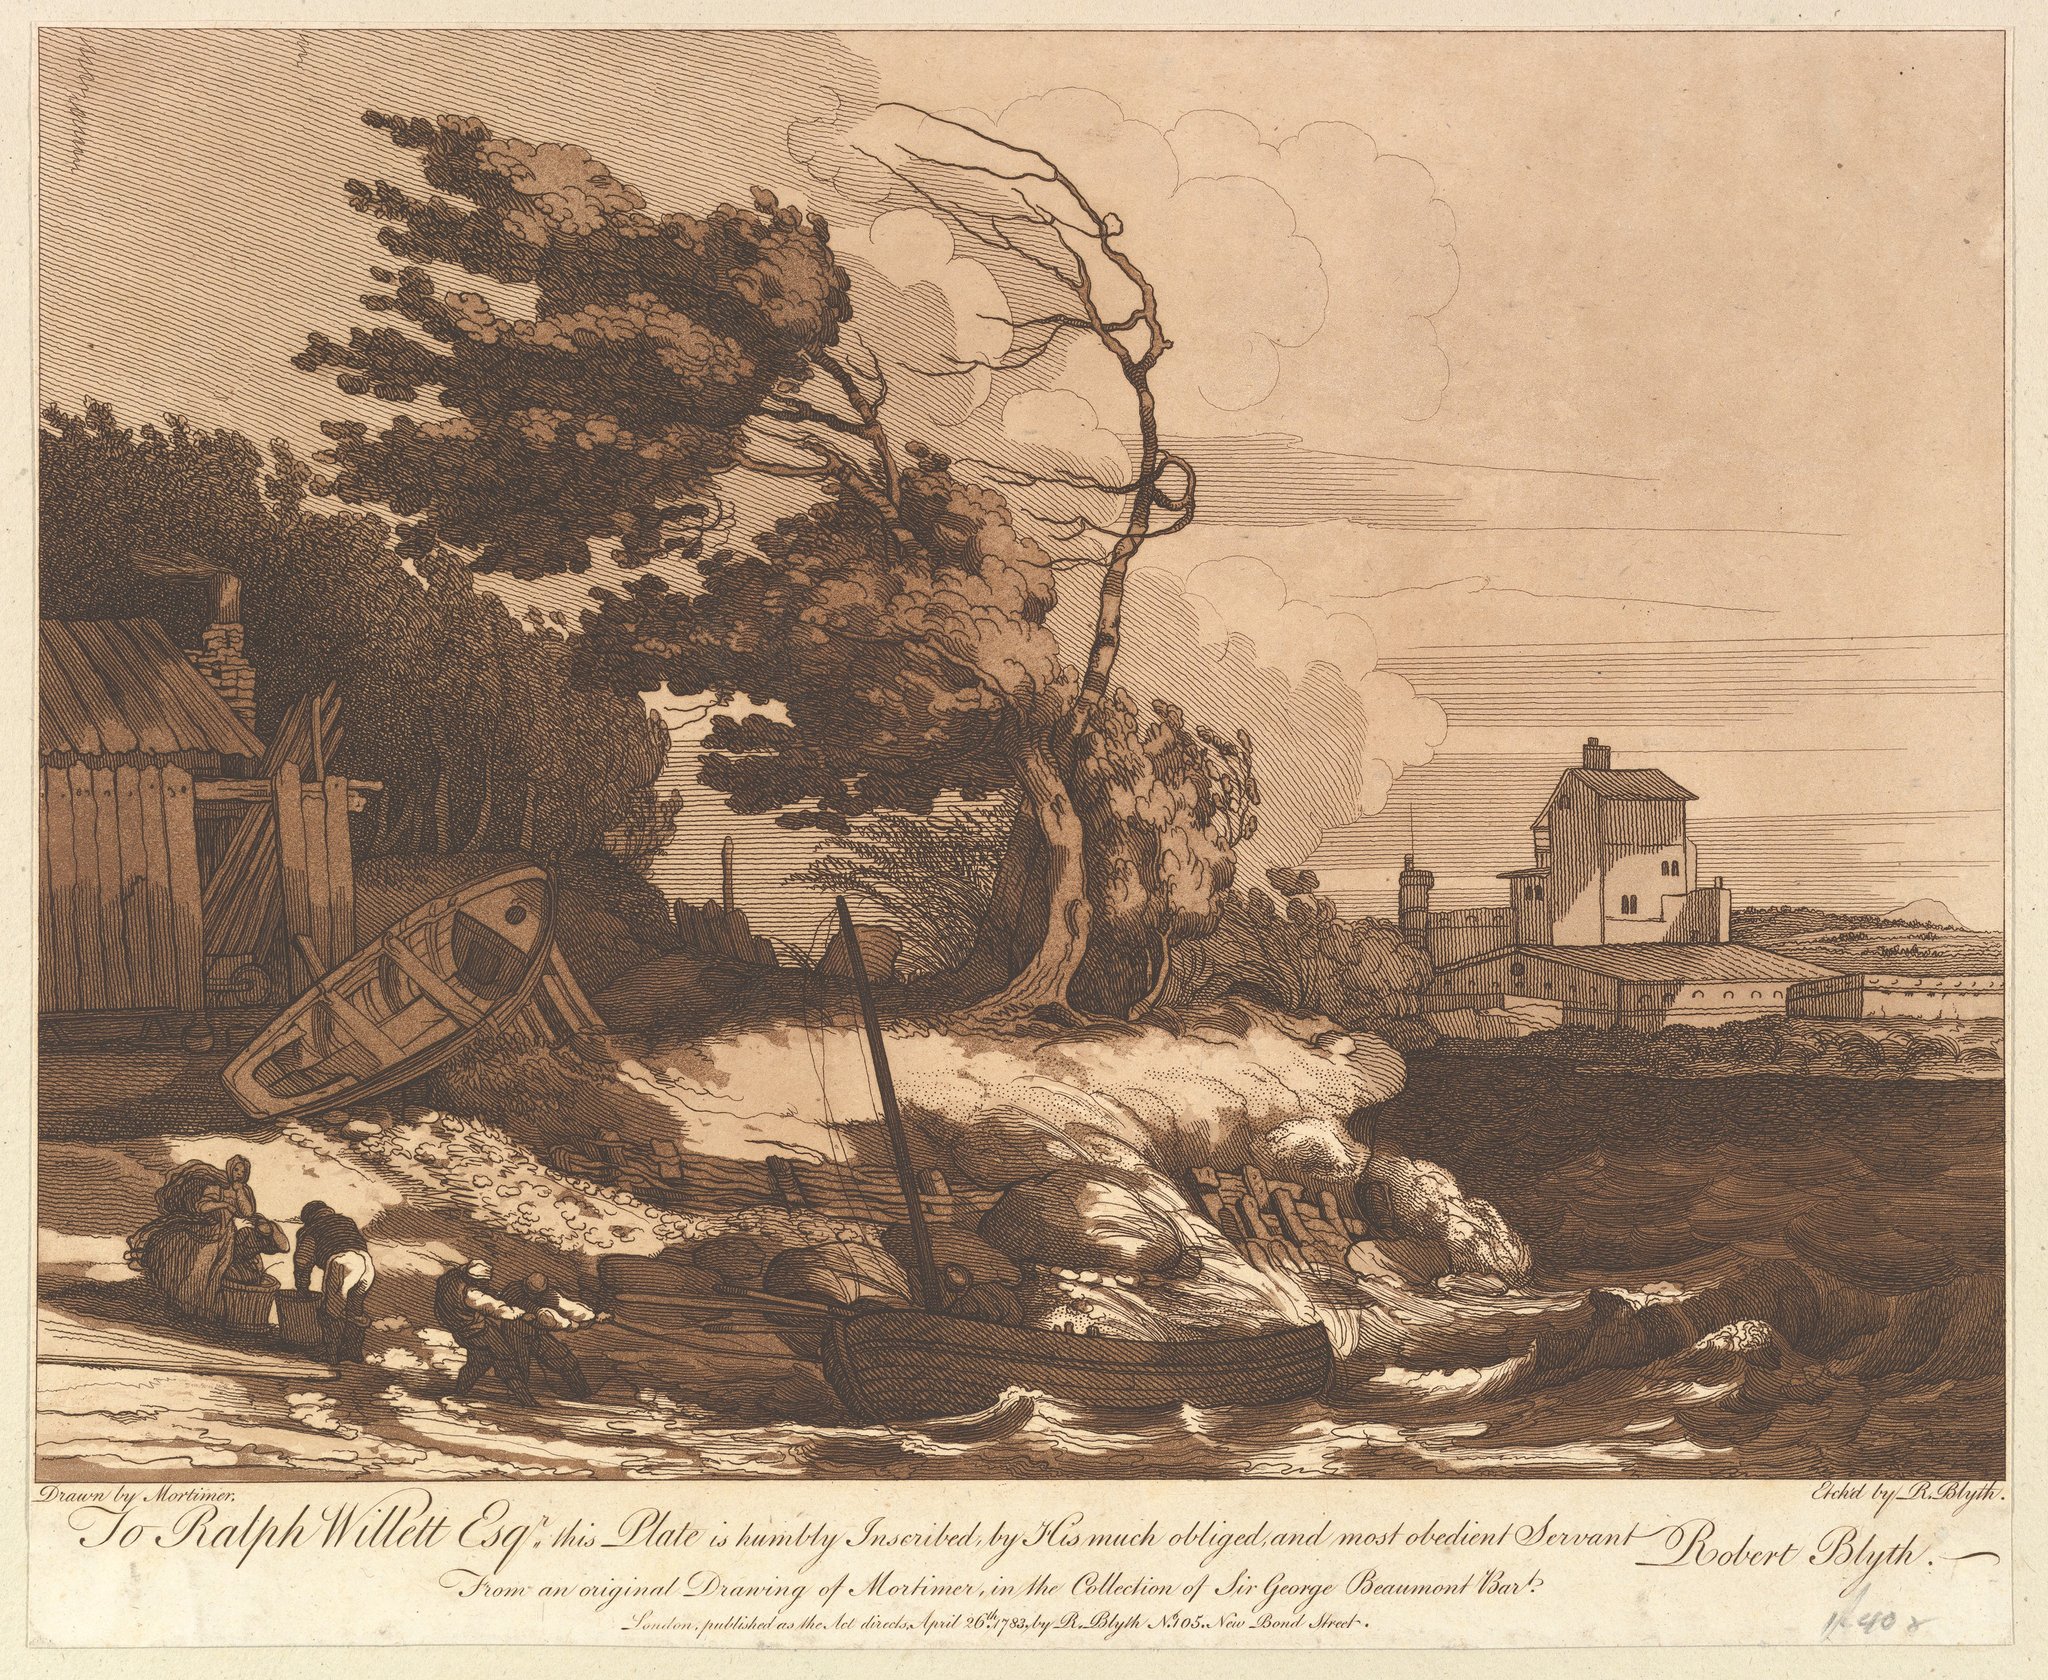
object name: print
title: Beaching a Fishing Boat in a Gale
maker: robert blyth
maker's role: artist and publisher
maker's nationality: british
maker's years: 1750-1784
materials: ink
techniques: aquatint, etching, printing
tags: houses,men,trees,working,boats